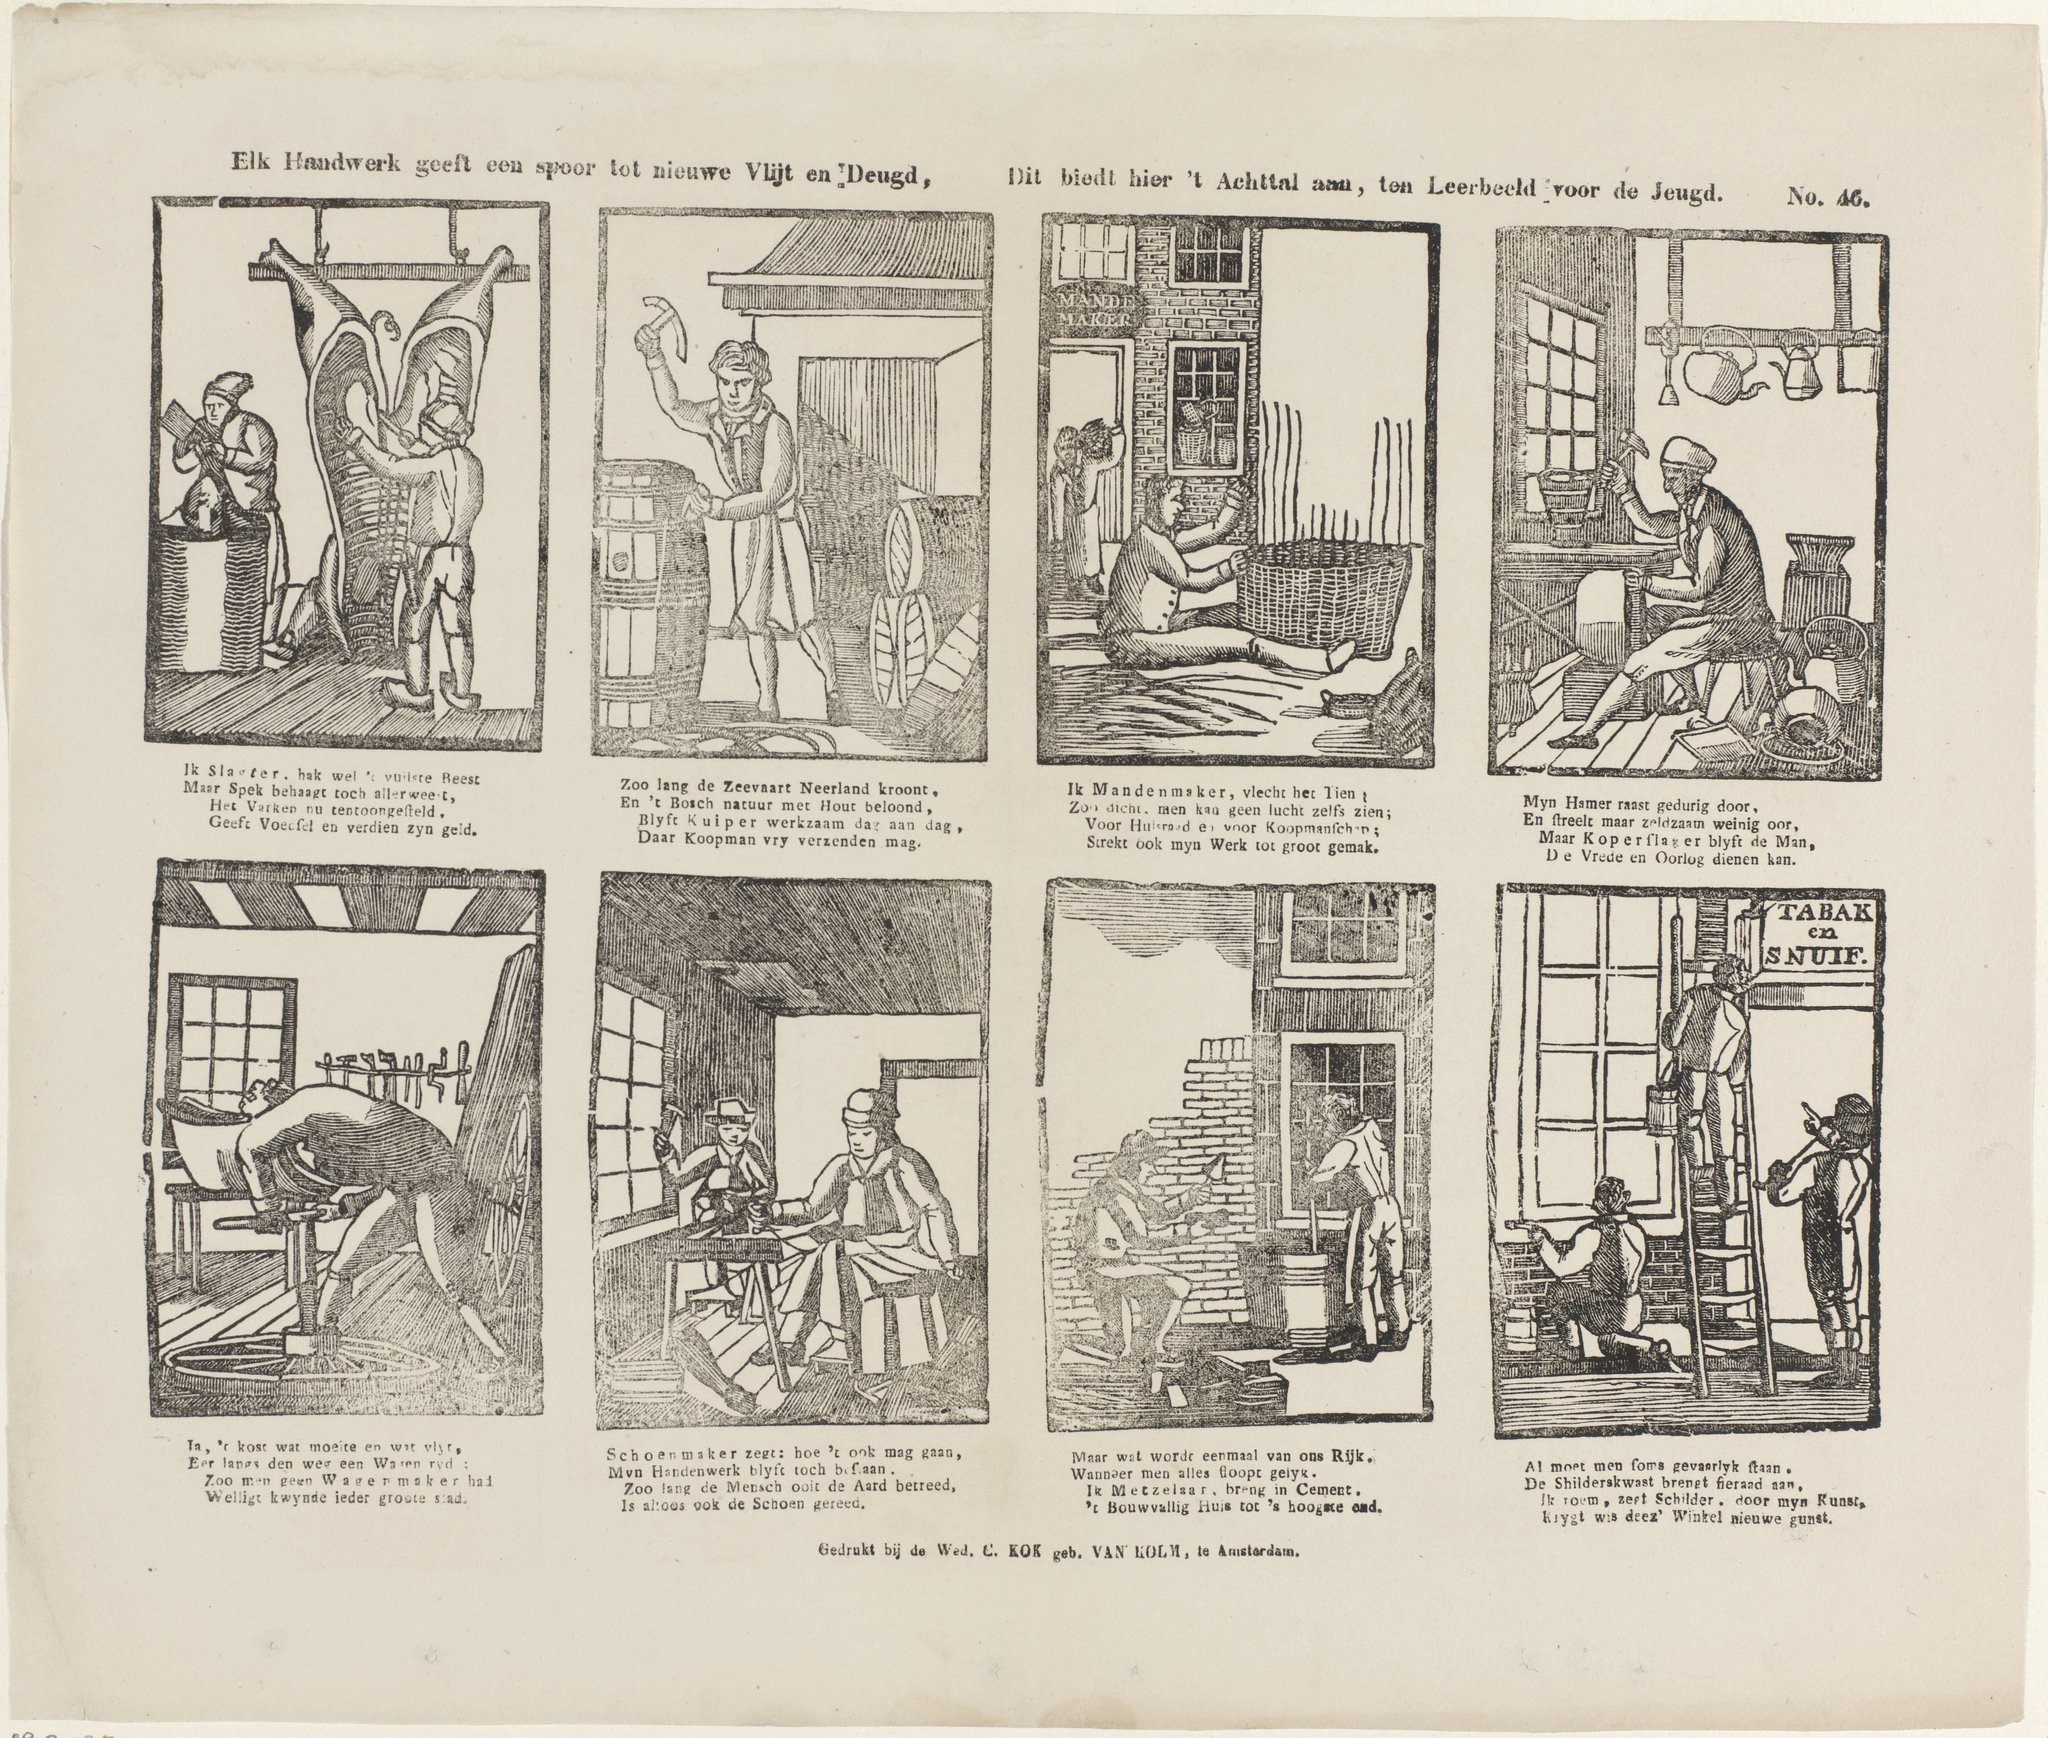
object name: popular print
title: Elk handwerk geeft een spoor tot nieuwe vlijt en deugd, / Dit biedt hier 't achttal aan, ten Leerbeeld voor de jeugd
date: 1842-1866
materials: paper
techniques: letterpress printing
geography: netherlands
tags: craft-production, skilled handiwork, butcher, slaughterman, mason at work, crafts and industries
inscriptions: collector's mark: Lugt 2760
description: Blad met 8 voorstellingen van ambachtslieden en beroepen, zoals slager, kuiper, mandenvlechter en metselaar. Onder elke afbeelding een vierregelig vers. Genummerd rechtsboven: No. 46.